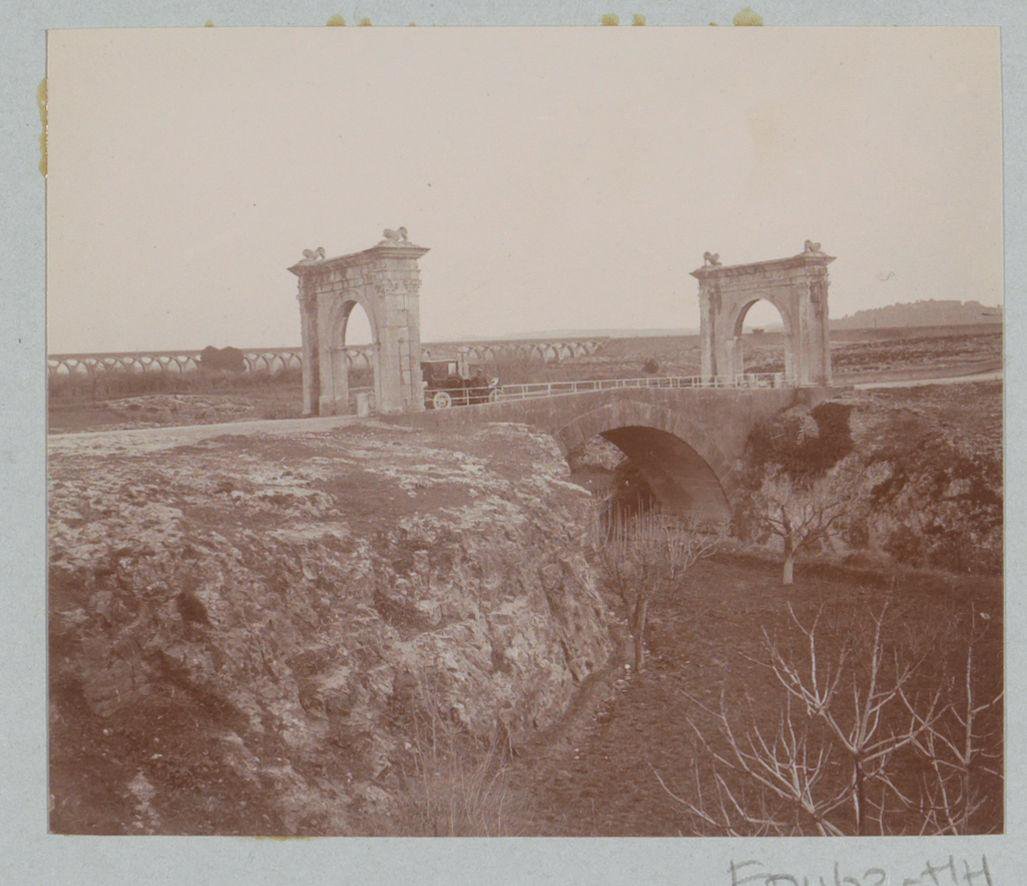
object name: photograph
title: Romeinse brug (Pont Flavien) in Saint-Chamas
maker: Anonymous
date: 1905-1910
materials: paper, photographic support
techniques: gelatin silver print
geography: saint-chamas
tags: landscape with bridge, viaduct or aqueduct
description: Onderdeel van Fotoalbum van een Franse amateurfotograaf met bezienswaardigheden in Frankrijk, Zwitserland en Italië.